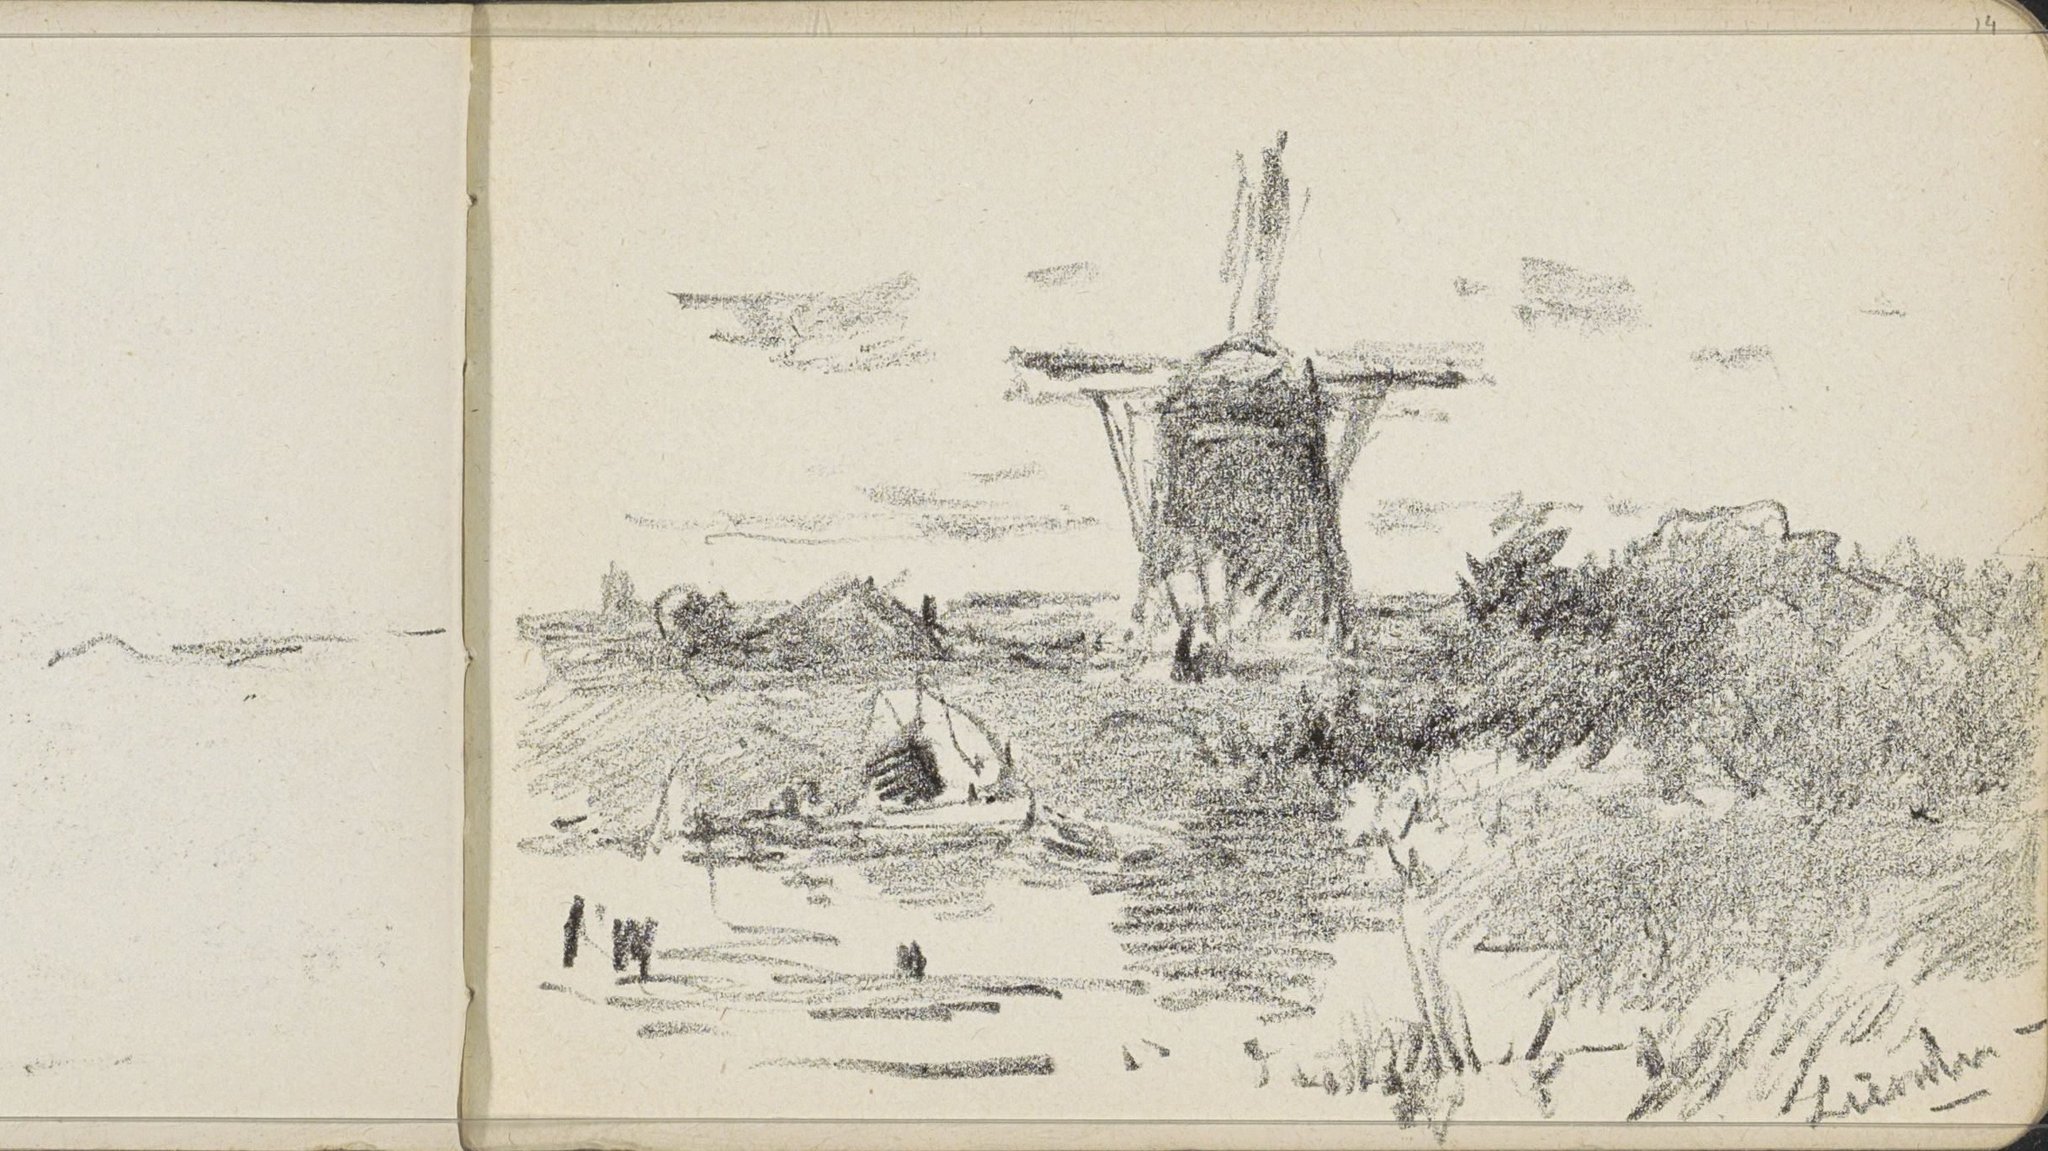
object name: sketchbook leaf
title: Molen De Zwaan te Lienden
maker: willem cornelis rip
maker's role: draughtsman, painter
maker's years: 1856-1922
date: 1905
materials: chalk, paper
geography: lienden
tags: windmill in landscape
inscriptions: annotation: ‘Lienden’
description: Blad 14 recto uit een schetsboek met 42 bladen.